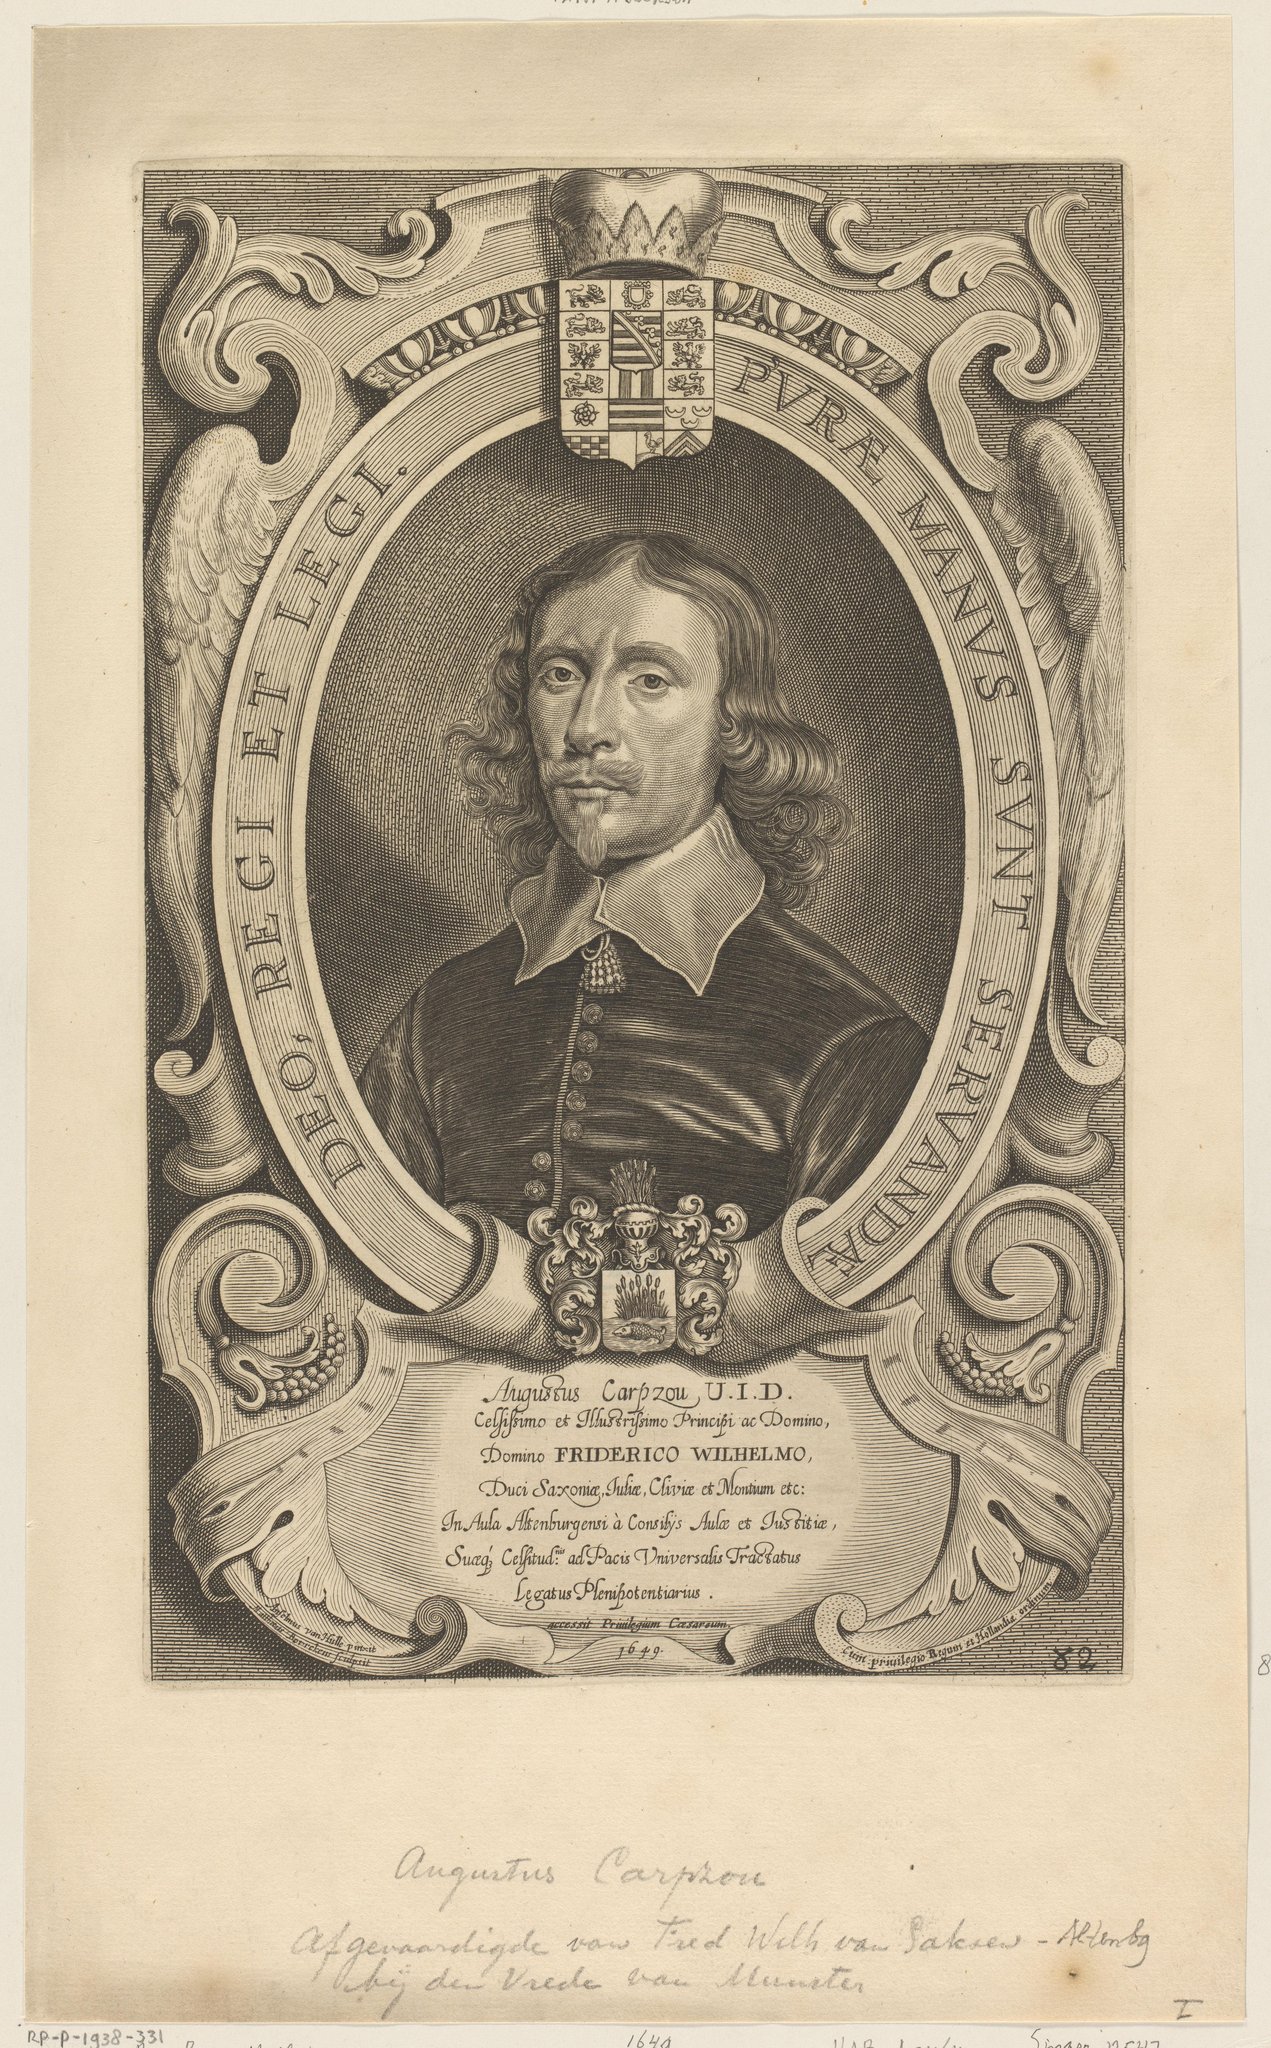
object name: print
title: Augustus Carpzou U.I.D. celsissimo et illustrissimo principi ac domino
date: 1713-1717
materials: paper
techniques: engraving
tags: historical persons, lawyer, attorney at law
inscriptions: collector's mark: Lugt 2228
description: Prent is gebruikt in verschillende series. De huidige staat is gebruikt in de hieronder vermelde serie en uitgaven (6) en (7). (1)‘Legati Celeberrimi’, uitgegeven door Daniel Middeler in 1648 in Antwerpen. (2)‘Legati Celeberrimi’, waarschijnlijk uitgegeven in 1651, maar opnieuw met de vermelding door Daniel Middeler in 1648 in Antwerpen. (3)‘Legati Celeberrimi', waarschijnlijk uitgegeven in 1658, maar opnieuw met de vermelding door Daniel Middeler in 1648 in Antwerpen. (4) 'Pacificatores orbis Christiani, sive icones principum, ducum et legatorum, qui Monasterii atque Osnabrugae (...)', uitgegeven door Pieter van der Slaart in 1696 in Rotterdam. (5) 'Pacificatores orbis Christiani, sive icones principum, ducum et legatorum, qui Monasterii atque Osnabrugae (...)', uitgegeven door Pieter van der Slaart in 1697 in Rotterdam. (6) 'Pacificatores orbis Christiani, sive icones principum, ducum et legatorum, qui Monasterii atque Osnabrugae (...)', waarschijnlijk uitgegeven circa 1713, maar opnieuw met vermelding van Pieter van der Slaart in 1697 in Rotterdam. De platen in deze uitgave zijn voor het eerst genummerd. (7) 'Les hommes illustres qui ont vécu dans le XXIIe siècle (...)', uitgegeven door David Mortier in 1717 in Rotterdam. Zie documentatie. Mogelijk zijn er nog meerdere uitgaven en staten van deze prent.